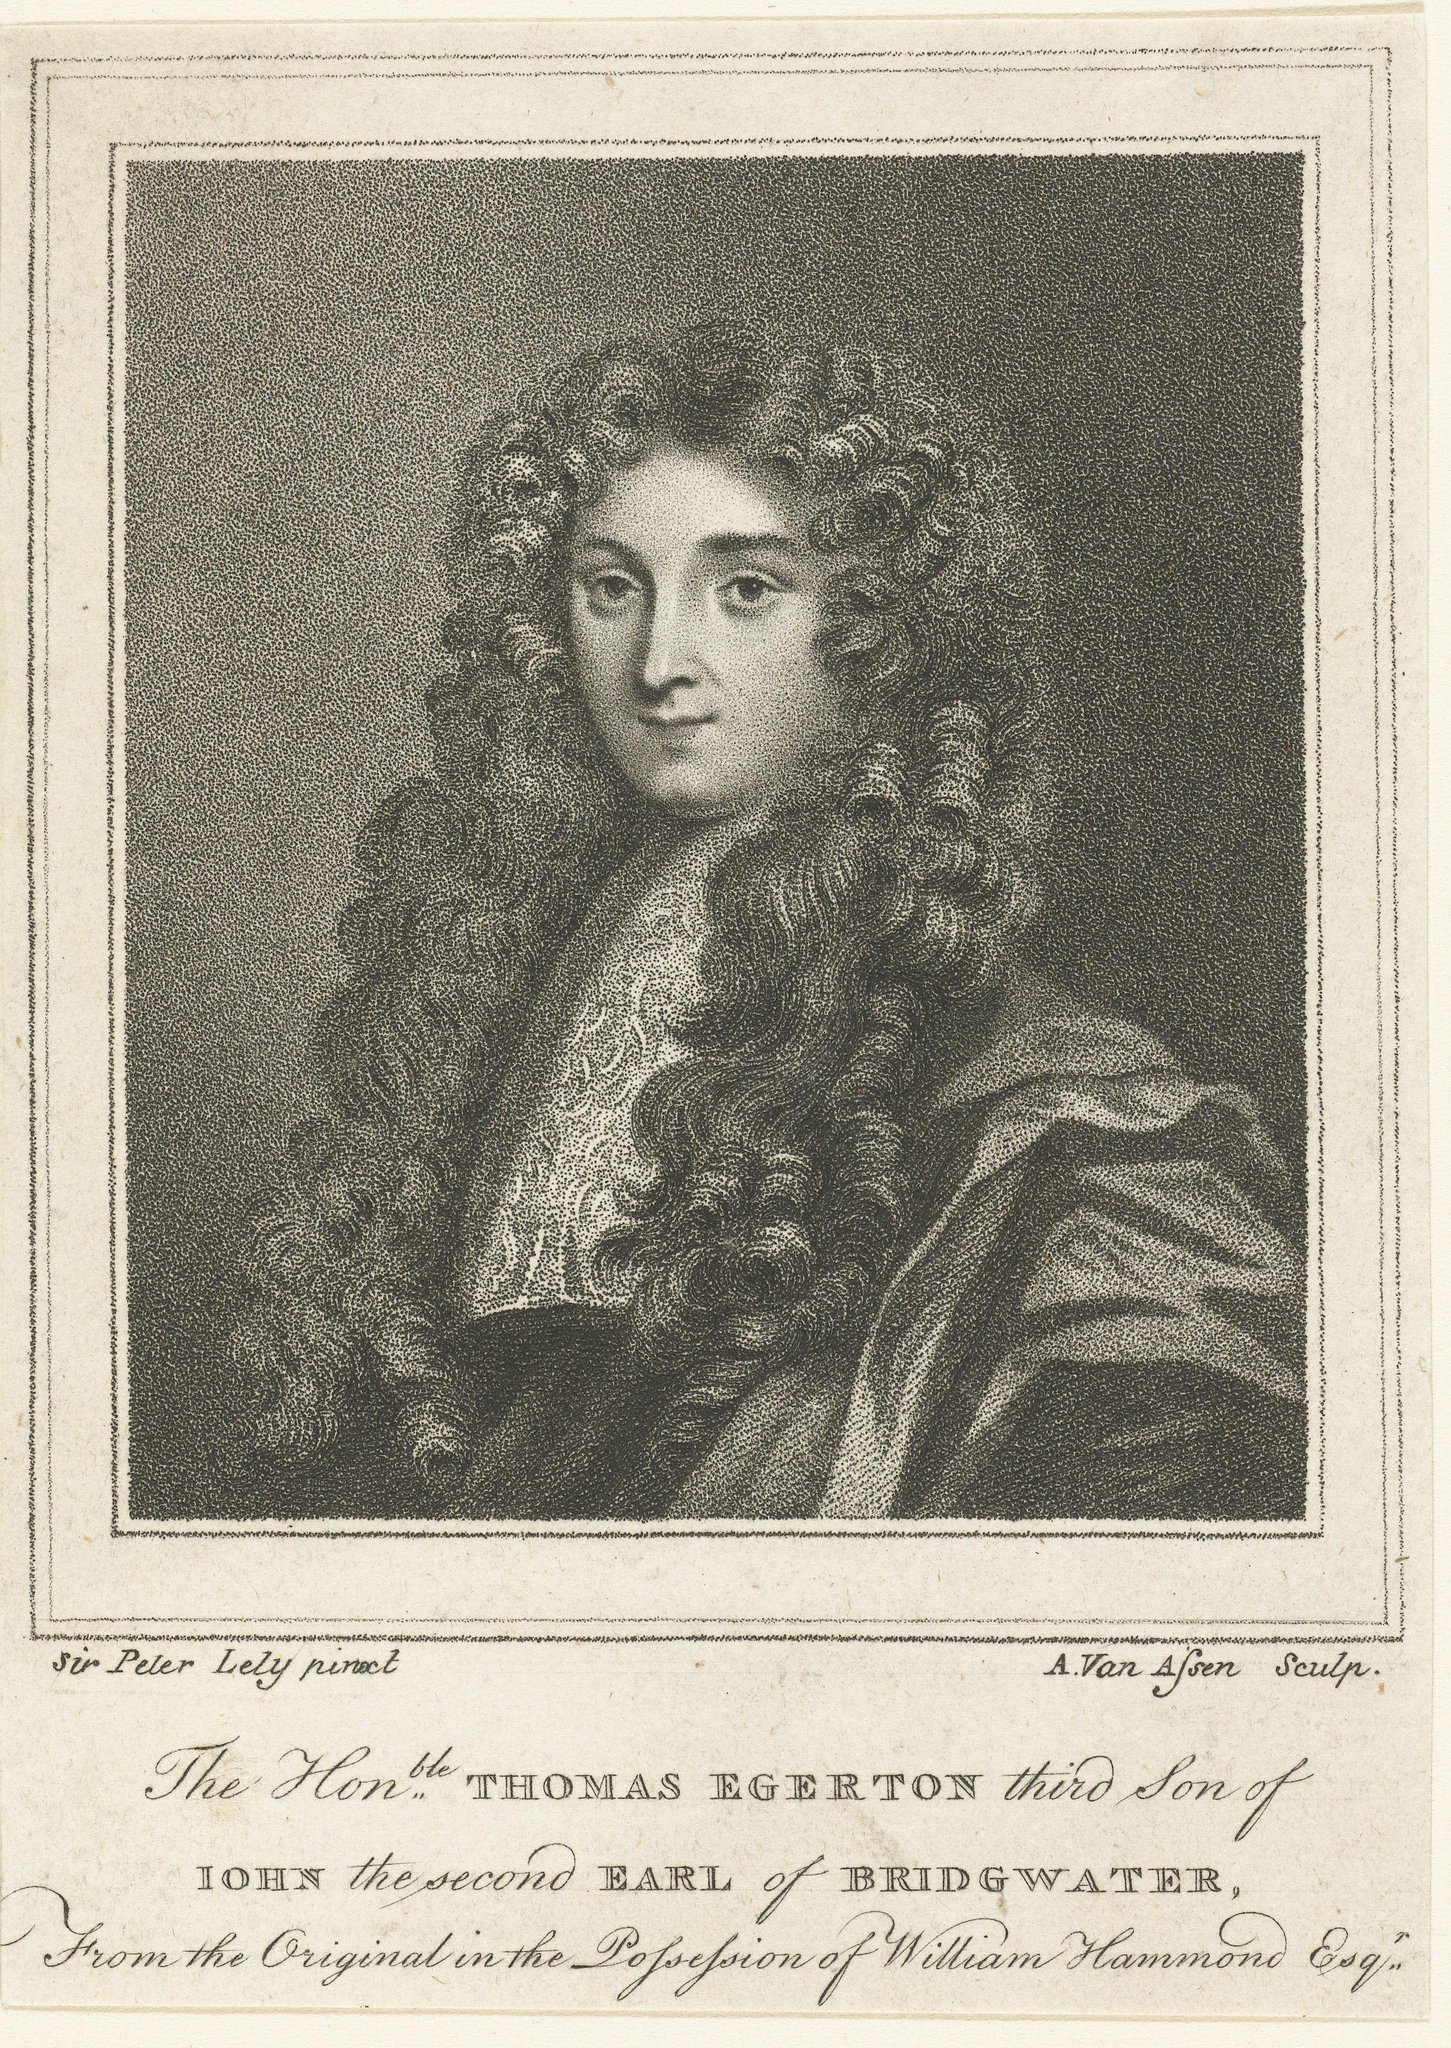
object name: print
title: Portret van Thomas Egerton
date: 1780-1817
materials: paper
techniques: engraving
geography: england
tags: thomas egerton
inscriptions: collector's mark: Lugt 2228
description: Portret van de jonge Thomas Egerton. Onder het portret zijn naam en familierelaties in het Engels.